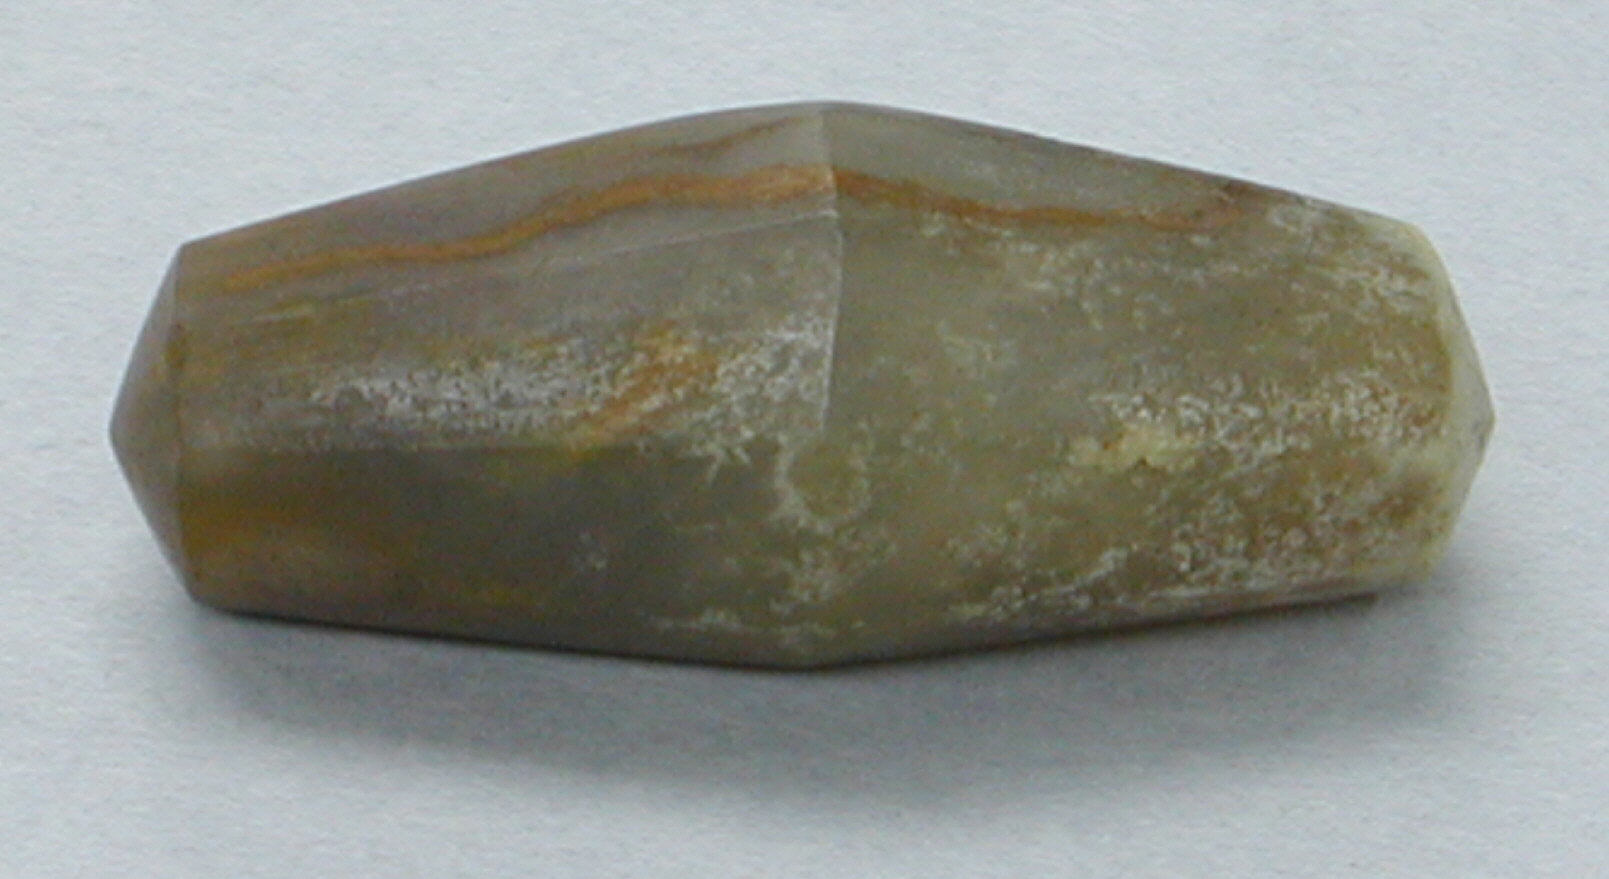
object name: ritual stone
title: Stone Pulidor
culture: mexican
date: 1501-1600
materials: stone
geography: mexico